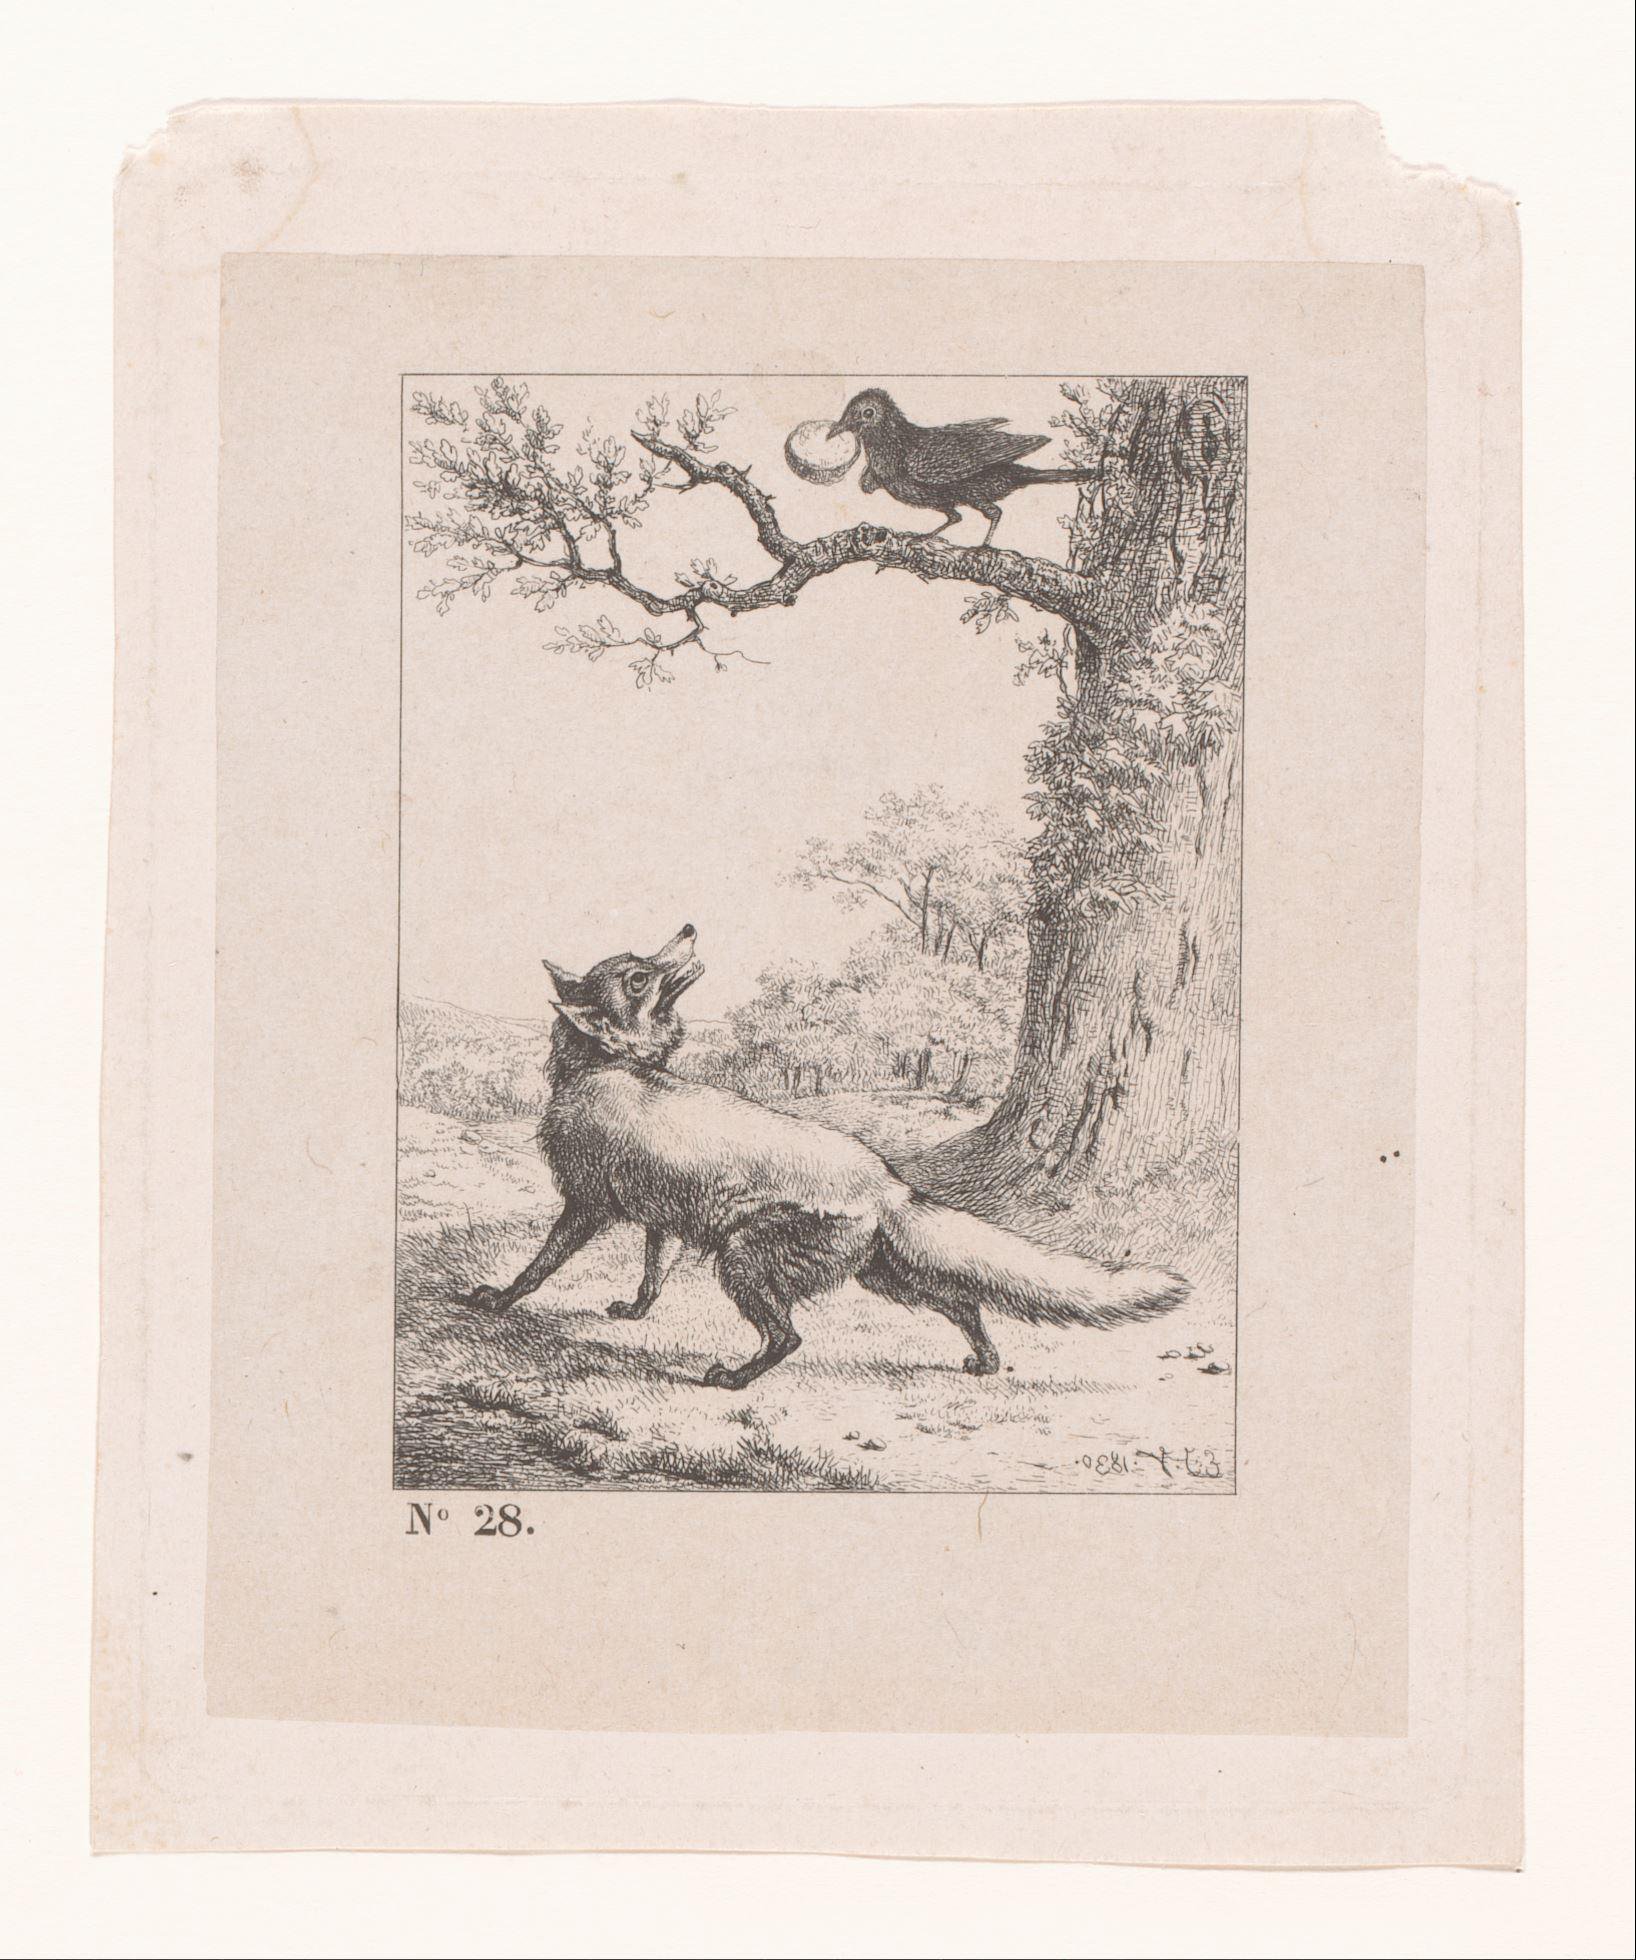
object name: print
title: Fabels van La Fontaine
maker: eugène verboeckhoven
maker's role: draughtsman, painter, print maker, printer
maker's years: 1798-1881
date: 1830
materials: paper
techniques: etching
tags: fable of the fox and the raven, song-birds: raven, beasts of prey, predatory animals: fox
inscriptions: number: ‘No 28.’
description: Prent maakt deel uit van een serie van acht prenten met scènes uit de fabels van Jean de La Fontaine.